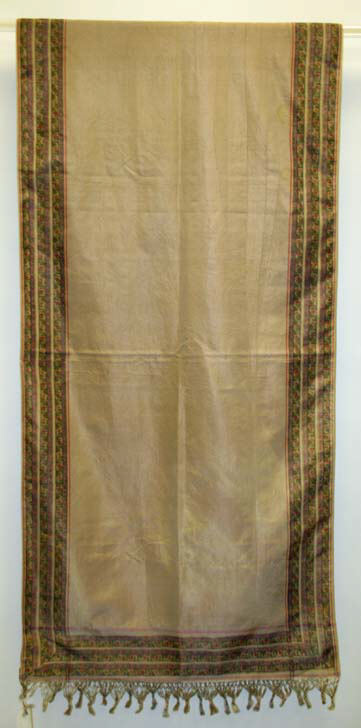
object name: shawl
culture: french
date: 1801-1825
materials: silk